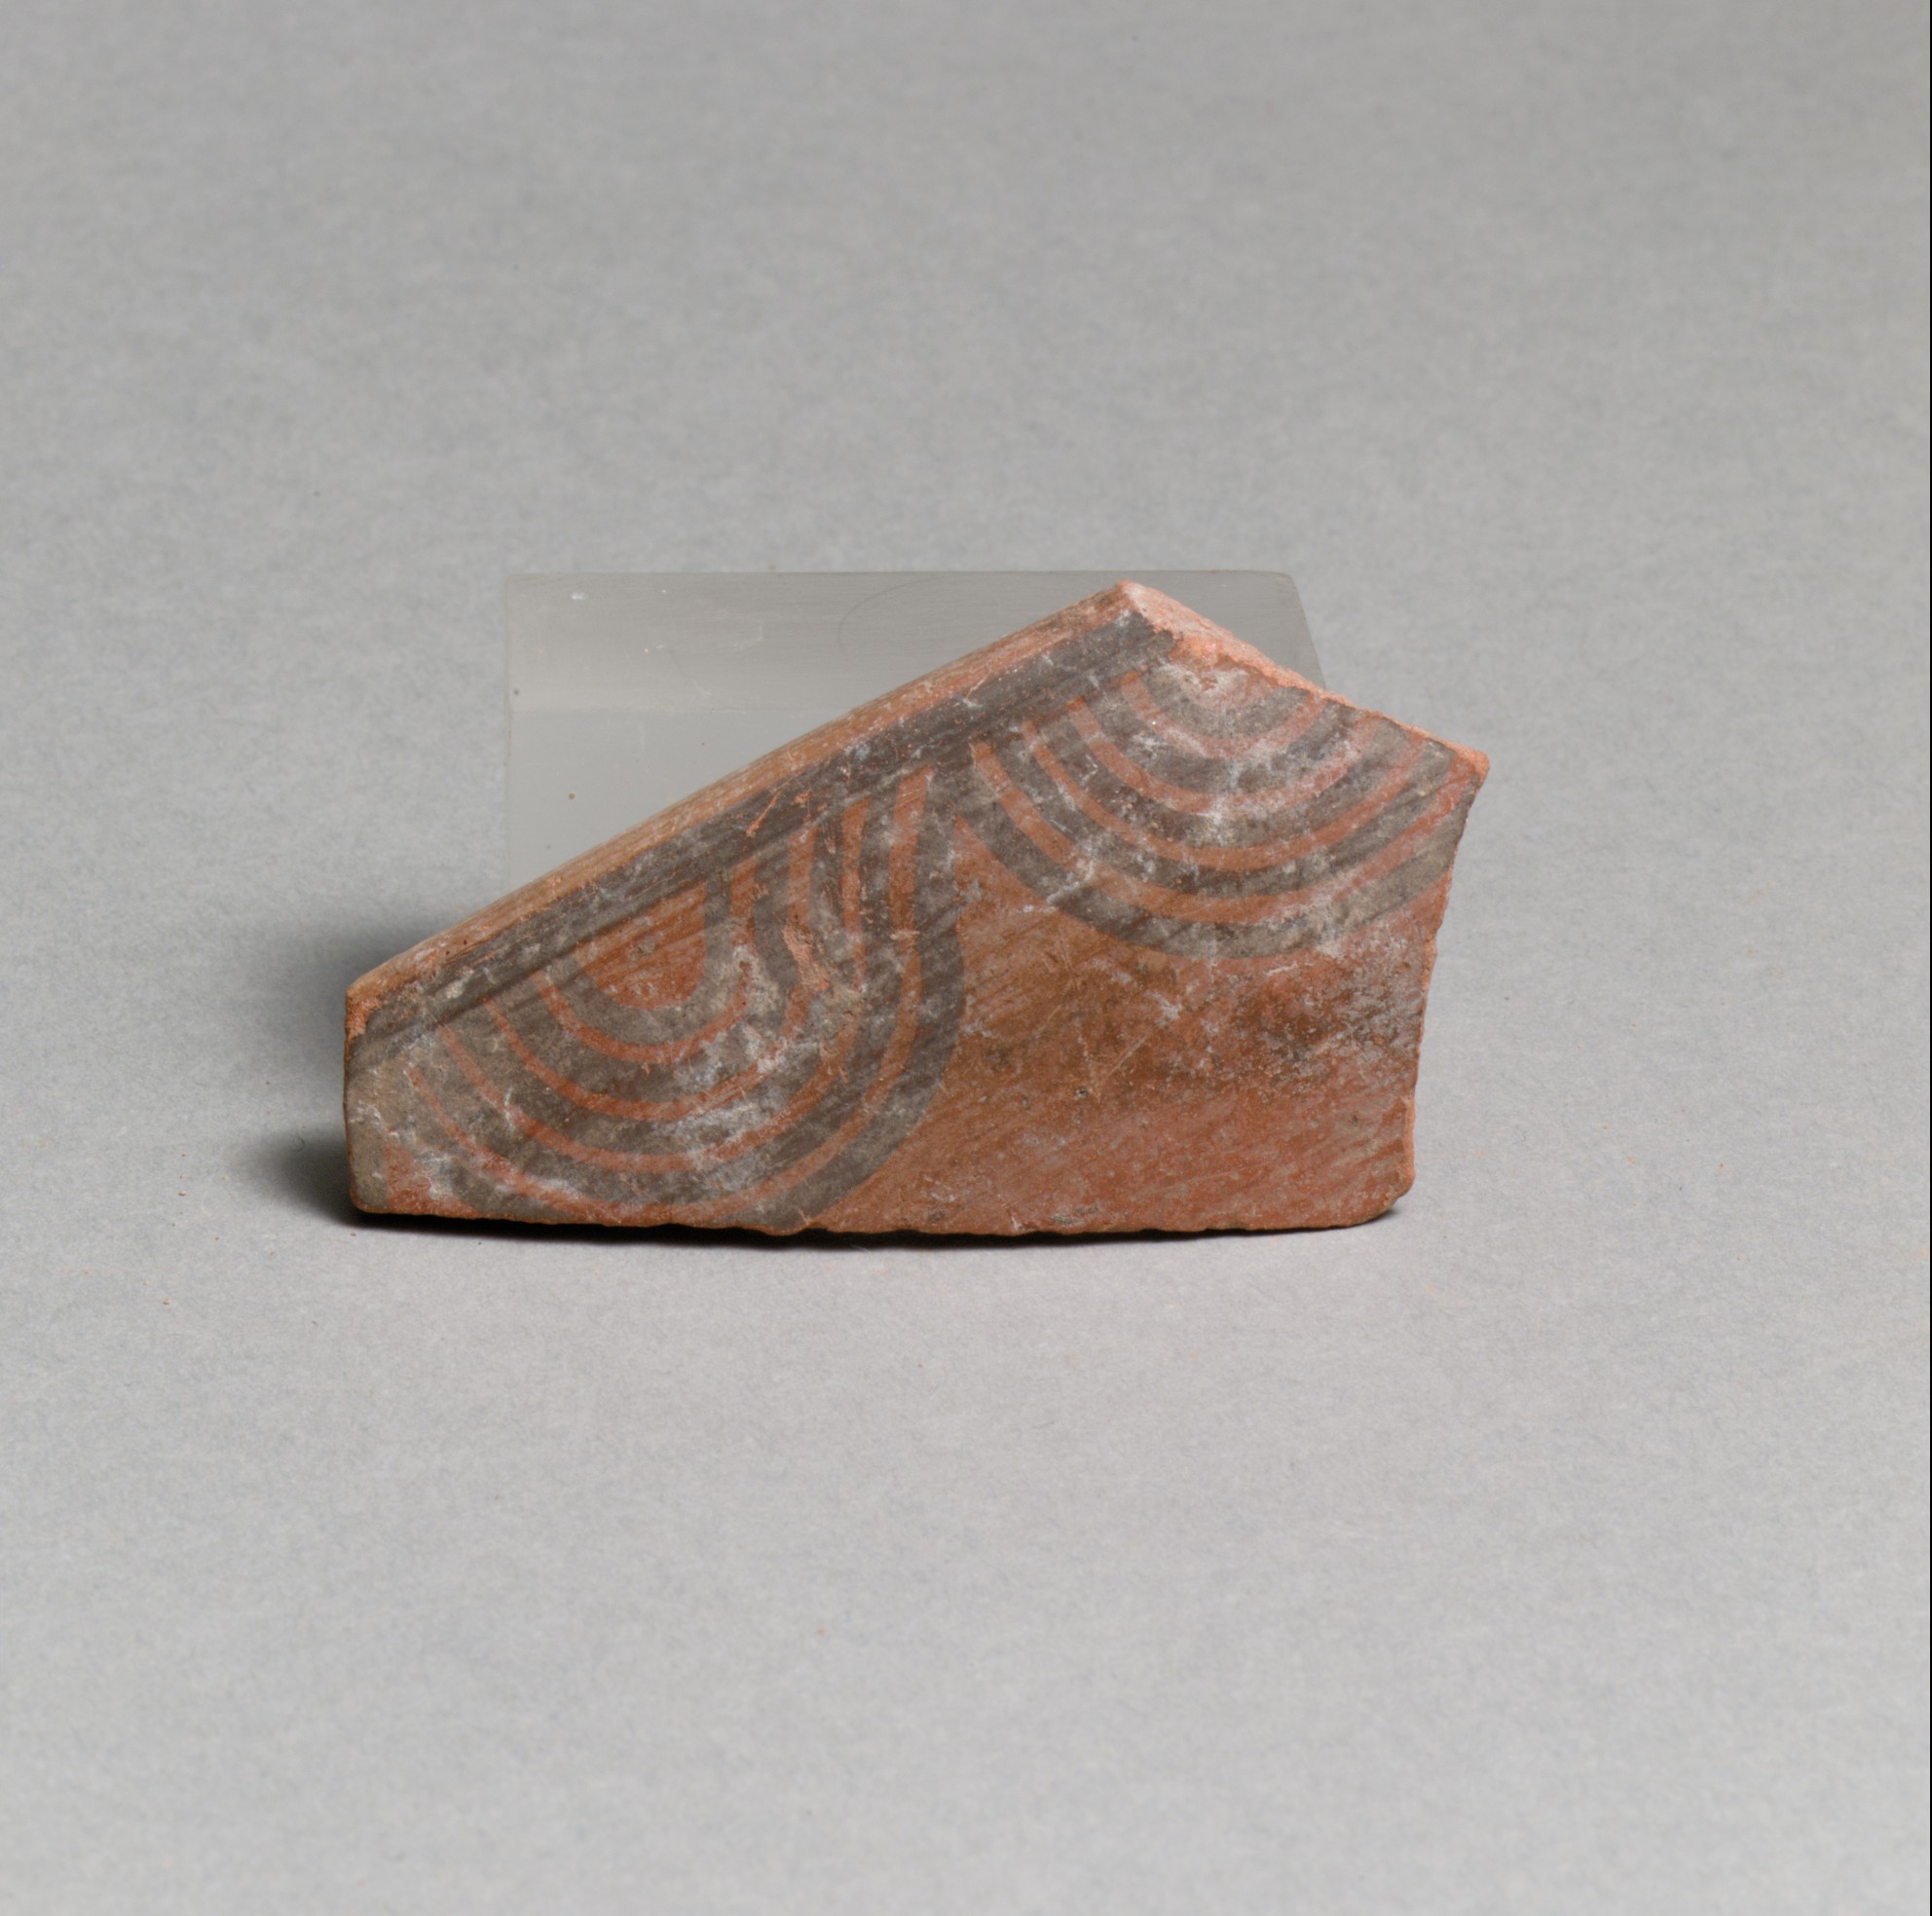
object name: vase fragment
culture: greek or lydian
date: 1050-700 BCE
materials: terracotta